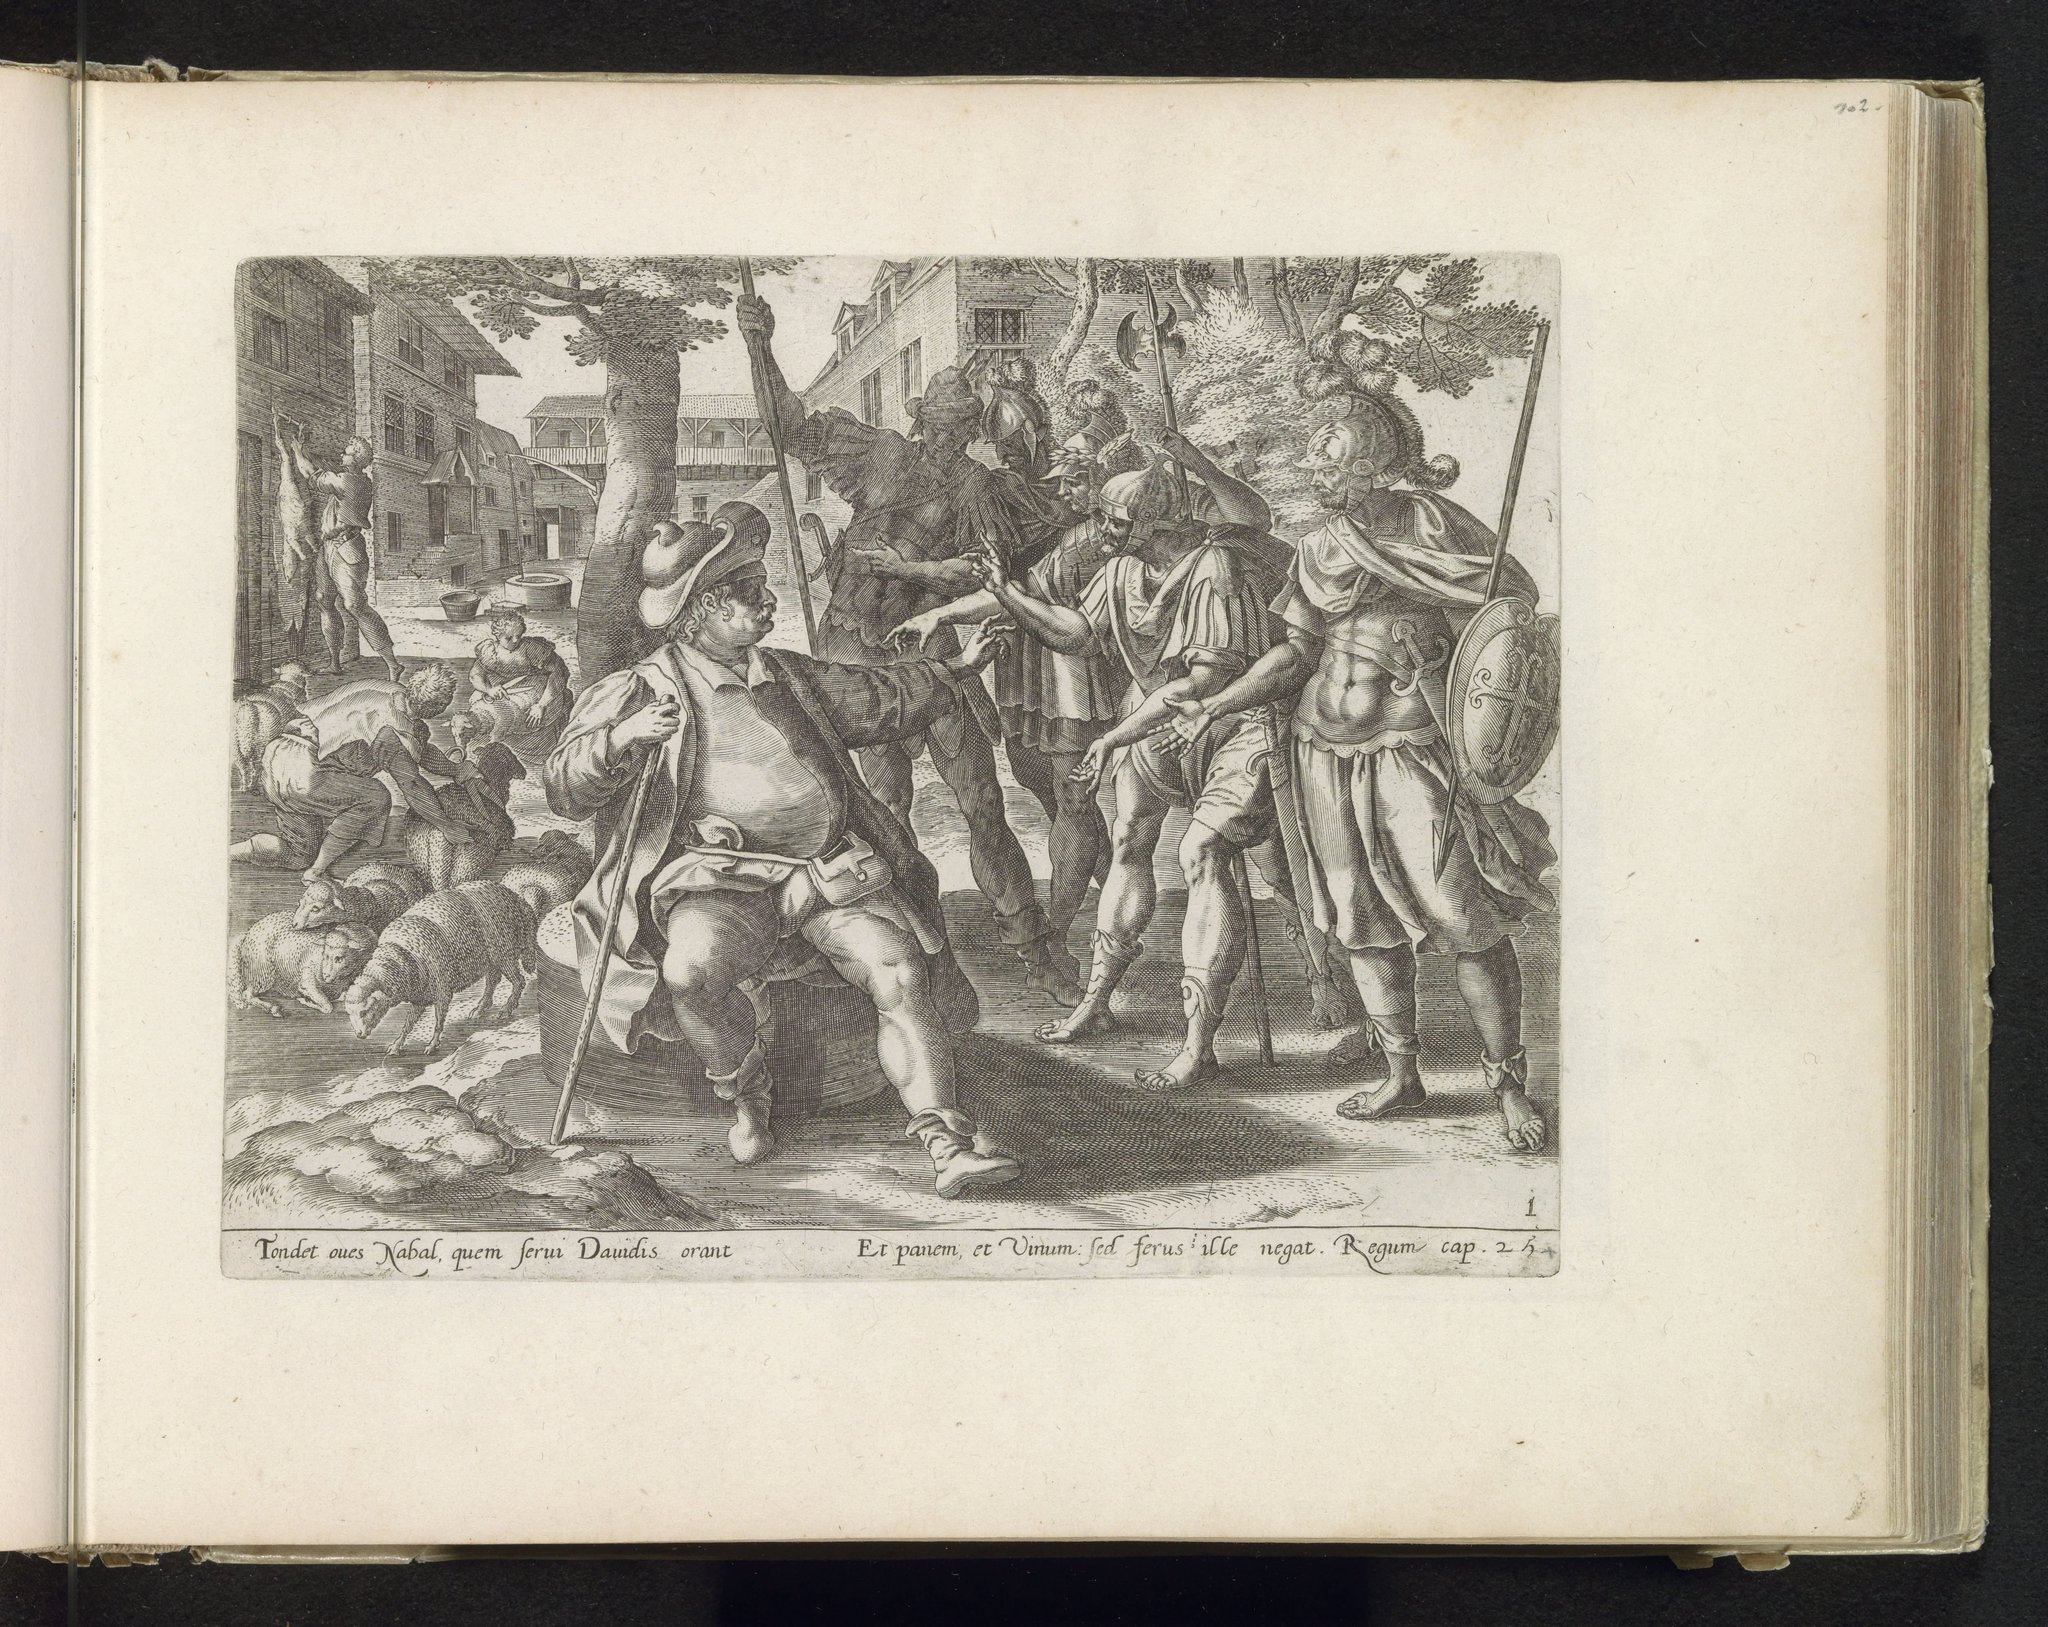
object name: album leaf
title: Davids mannen vragen Nabal om voedsel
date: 1585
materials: paper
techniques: engraving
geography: antwerp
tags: ten servants sent by david come to nabal to ask for food; nabal and his men may be shown shearing sheep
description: Davids knechten komen bij Nabal, die op de achtergrond zijn schapen laat scheren, en vragen hem om voedsel. Nabal weigert de mannen en David eten te geven. Onder de voorstelling een verwijzing in het Latijn naar de Bijbeltekst in 1 Sam. 25. Deze prent maakt deel uit van een album.